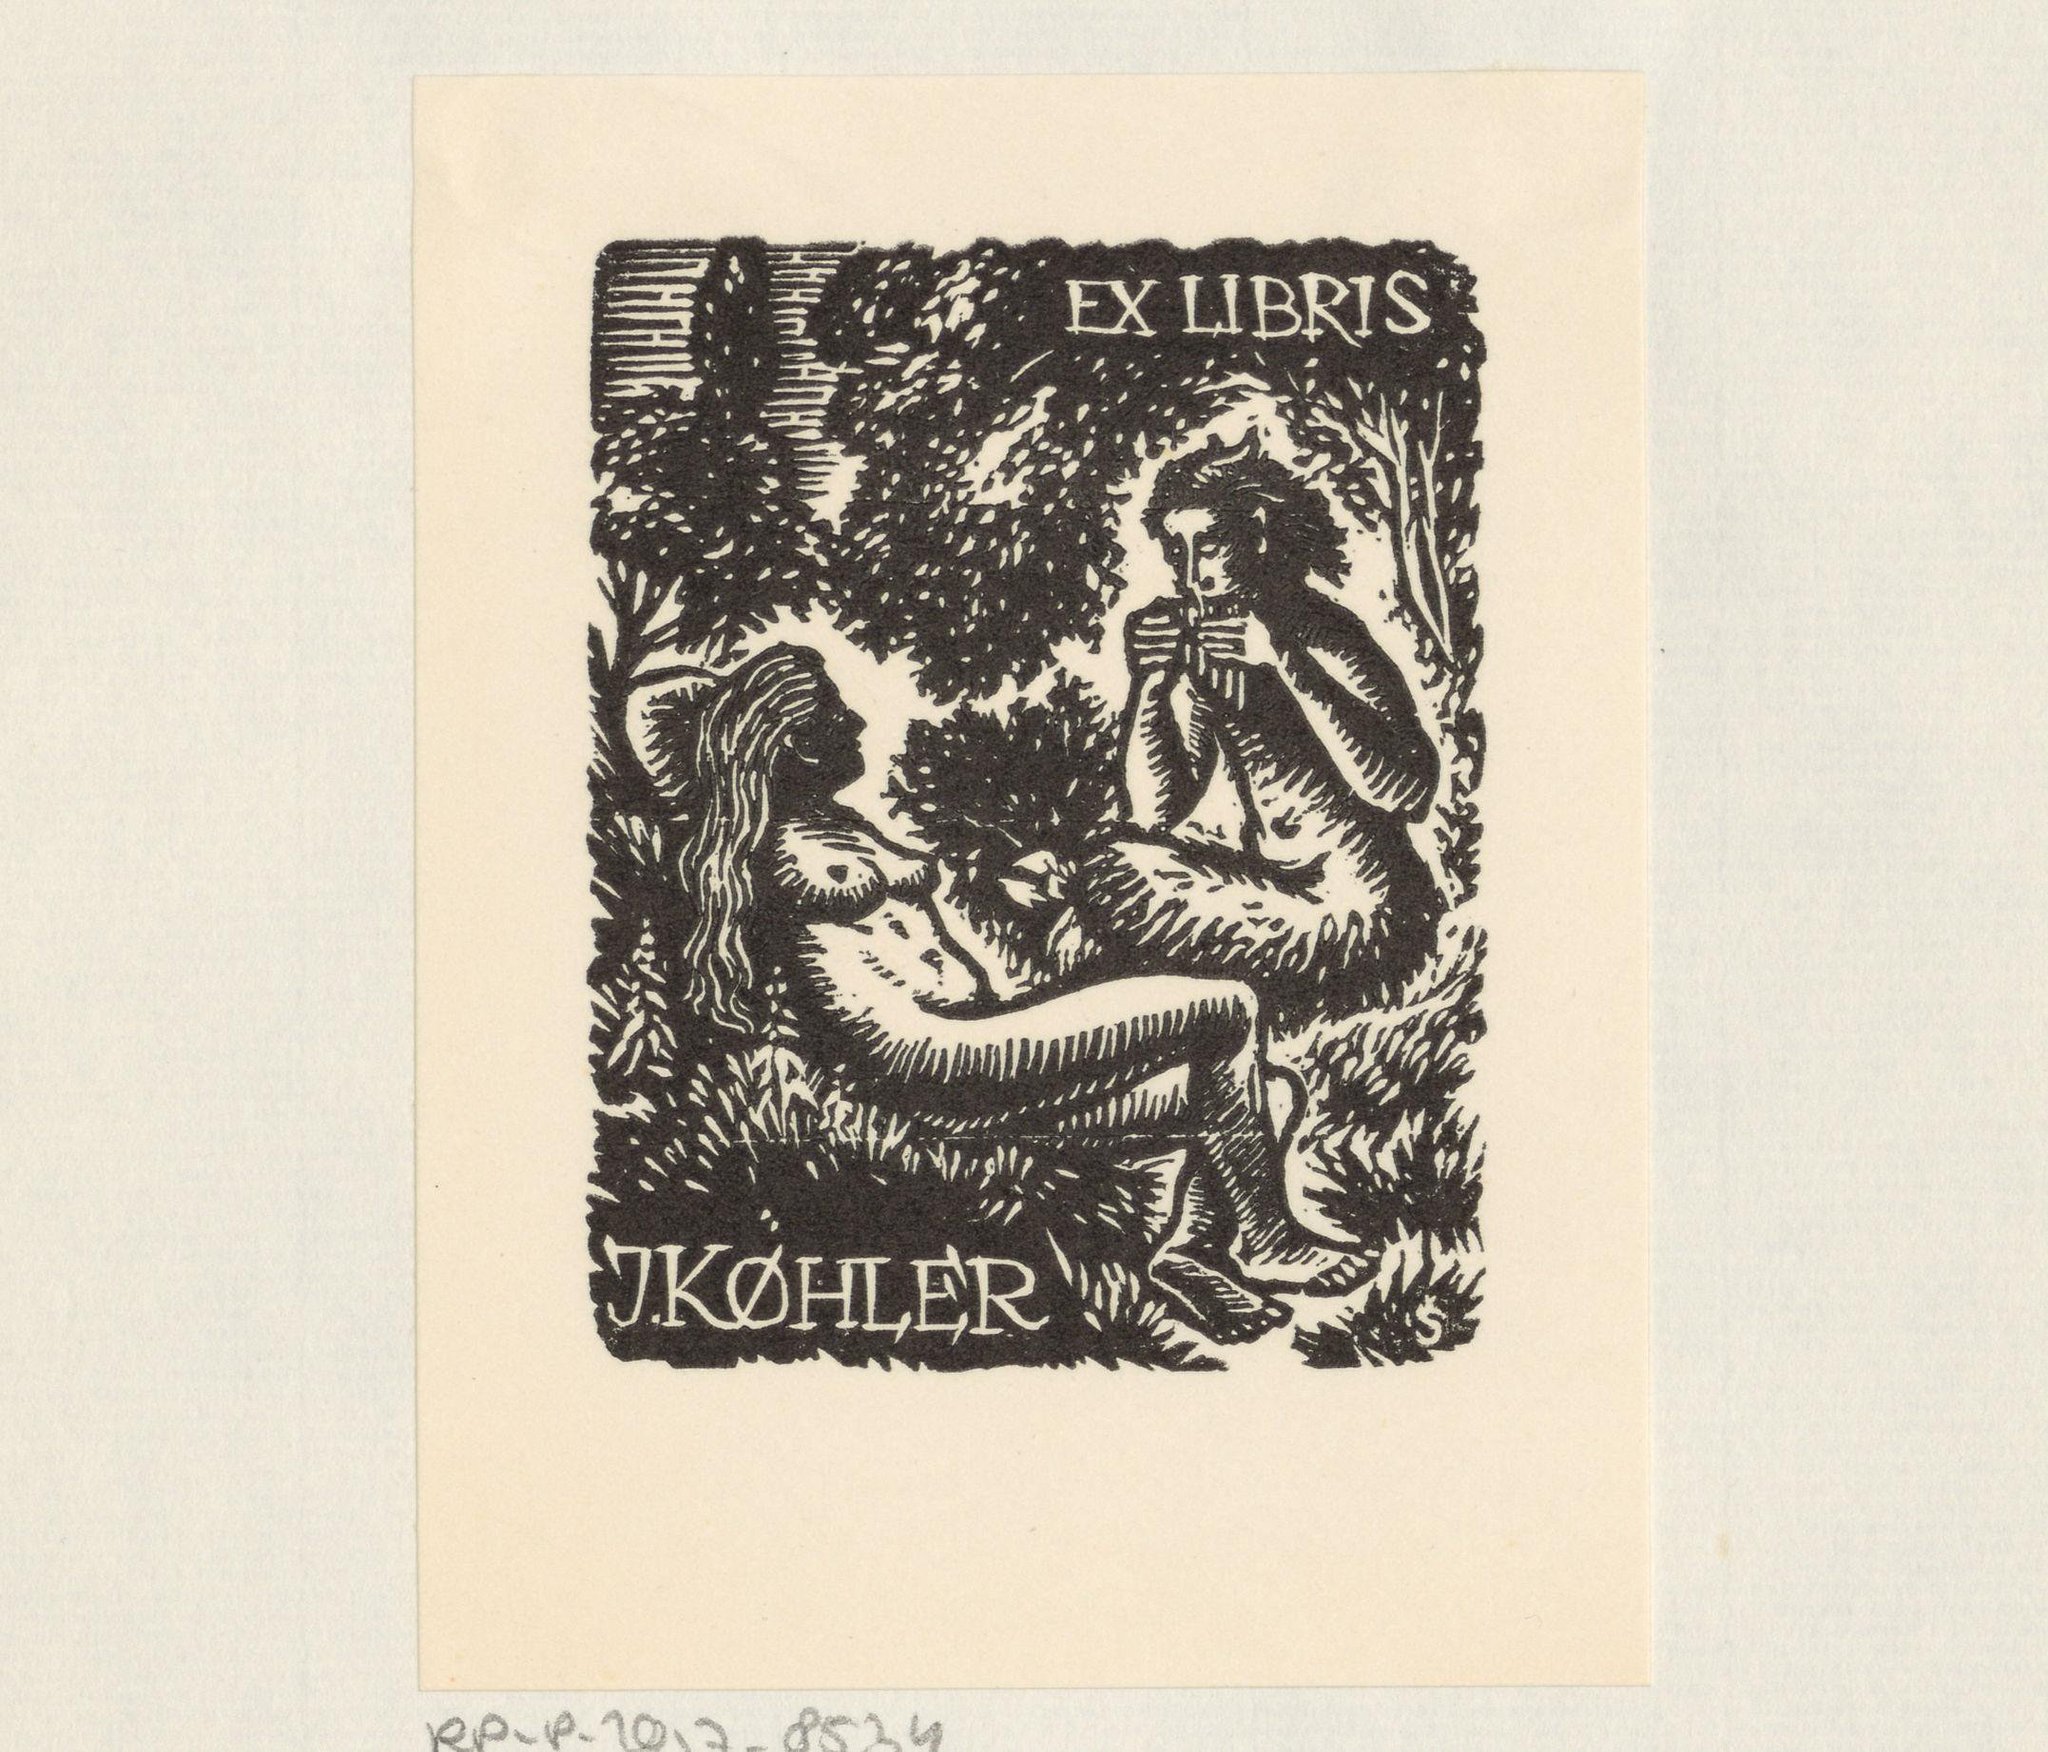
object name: bookplate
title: Ex libris van Johnny Køhler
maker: hugo silbersky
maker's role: print maker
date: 1958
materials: paper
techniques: woodcut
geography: czech republic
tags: satyrs, fauns, sileni, woman (showing herself) undressed, quasi-nude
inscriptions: workshop stamp: ‘Hugo Šilberský/ Czekoslovakia/ woodcut 1958’